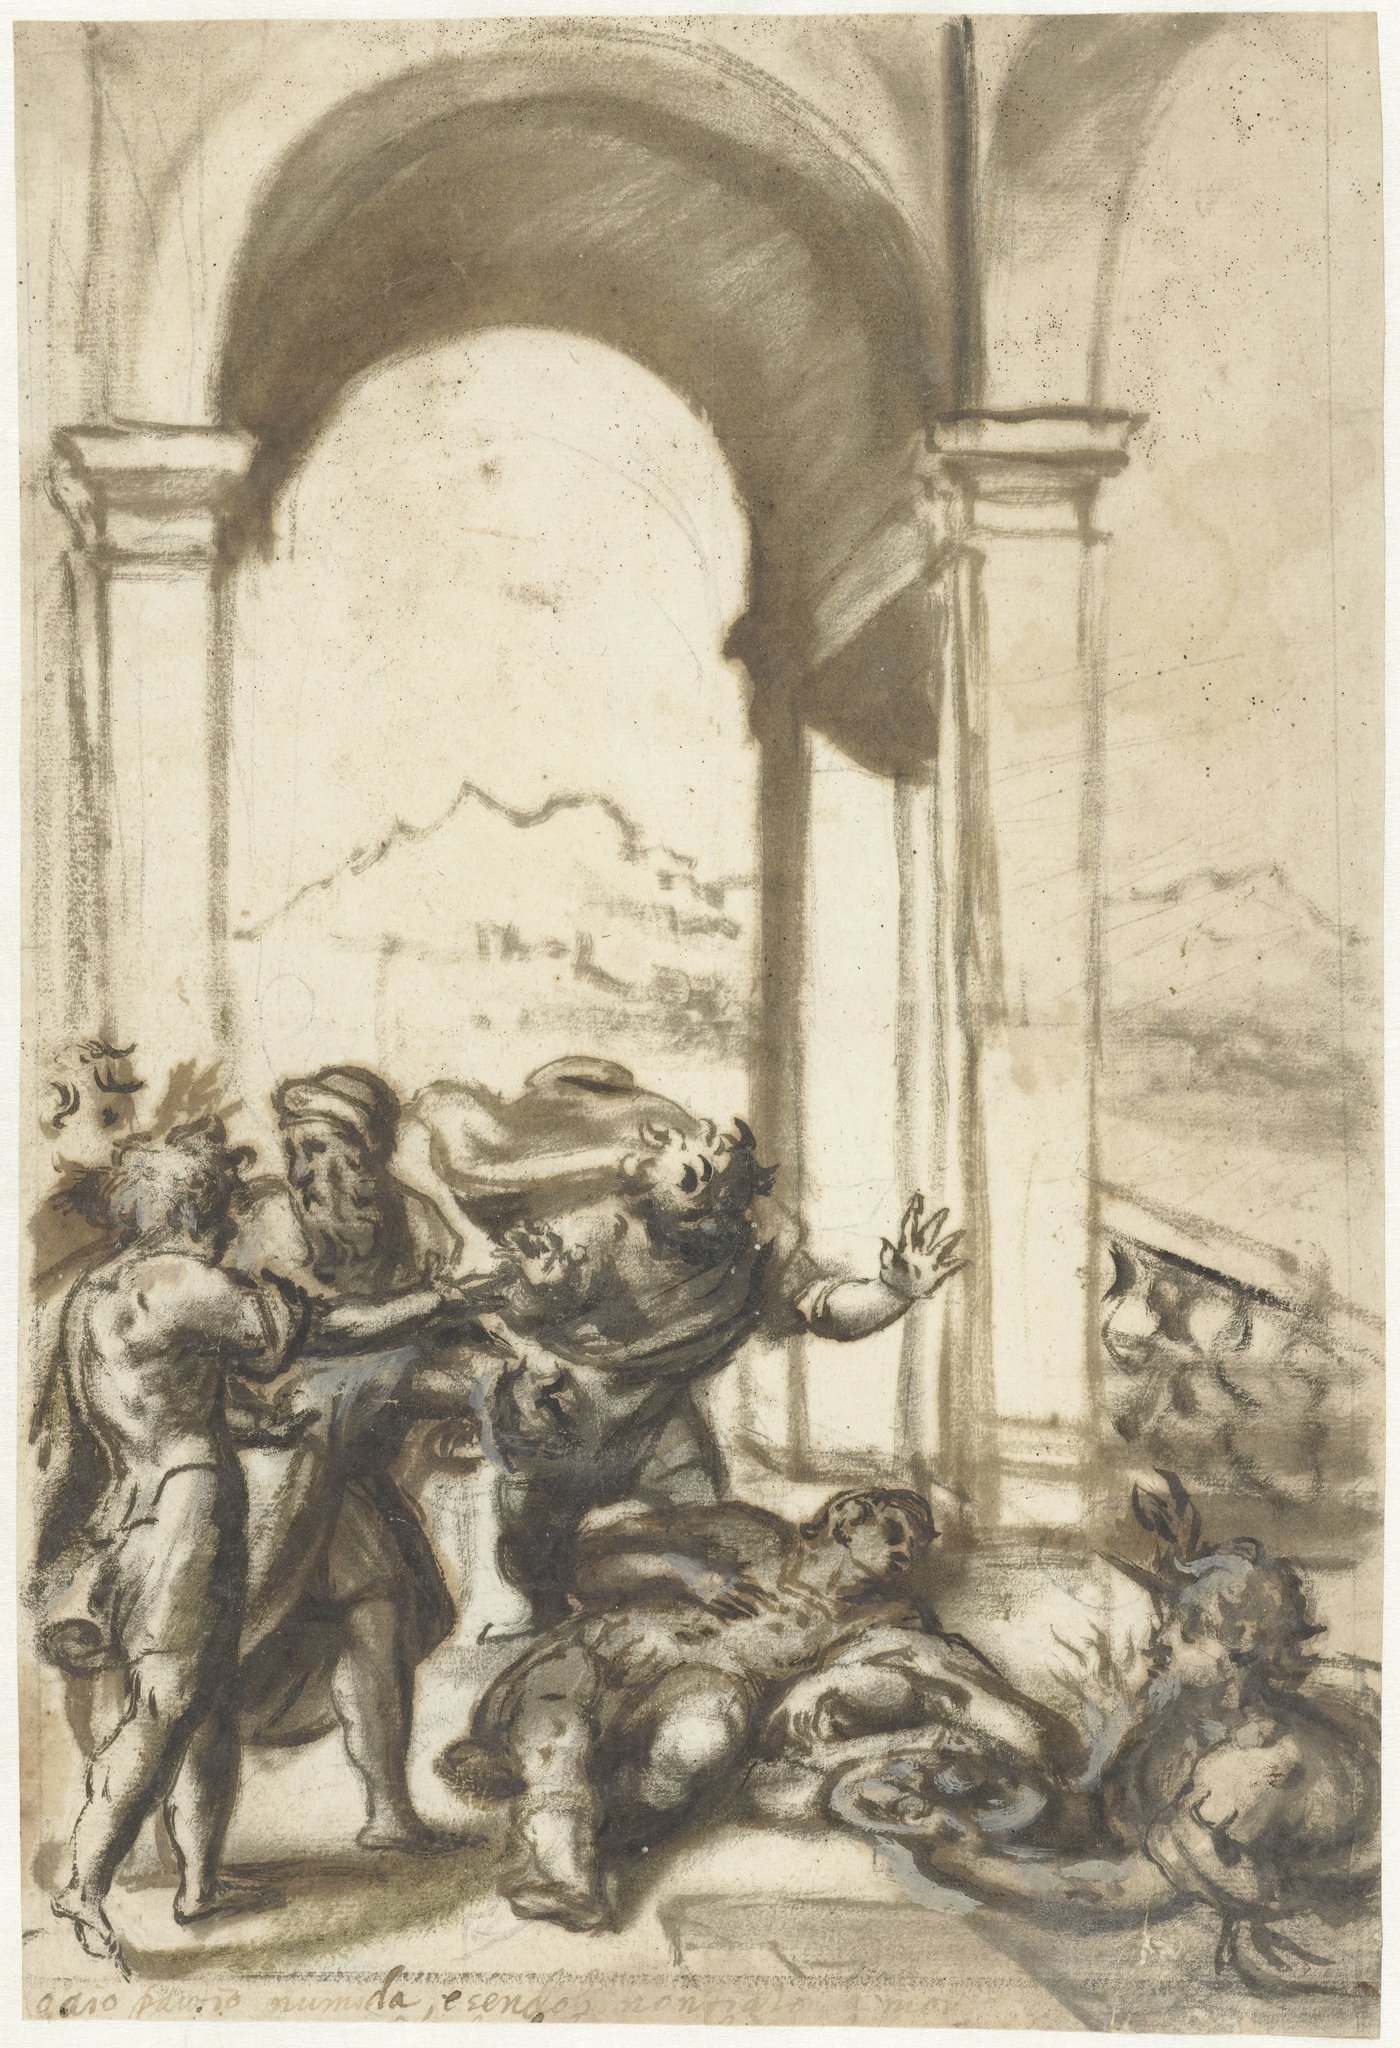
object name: drawing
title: Dood van Hannibal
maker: schiavone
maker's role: draughtsman, painter, print maker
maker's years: 1500-1563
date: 1510-1563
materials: paper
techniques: brush